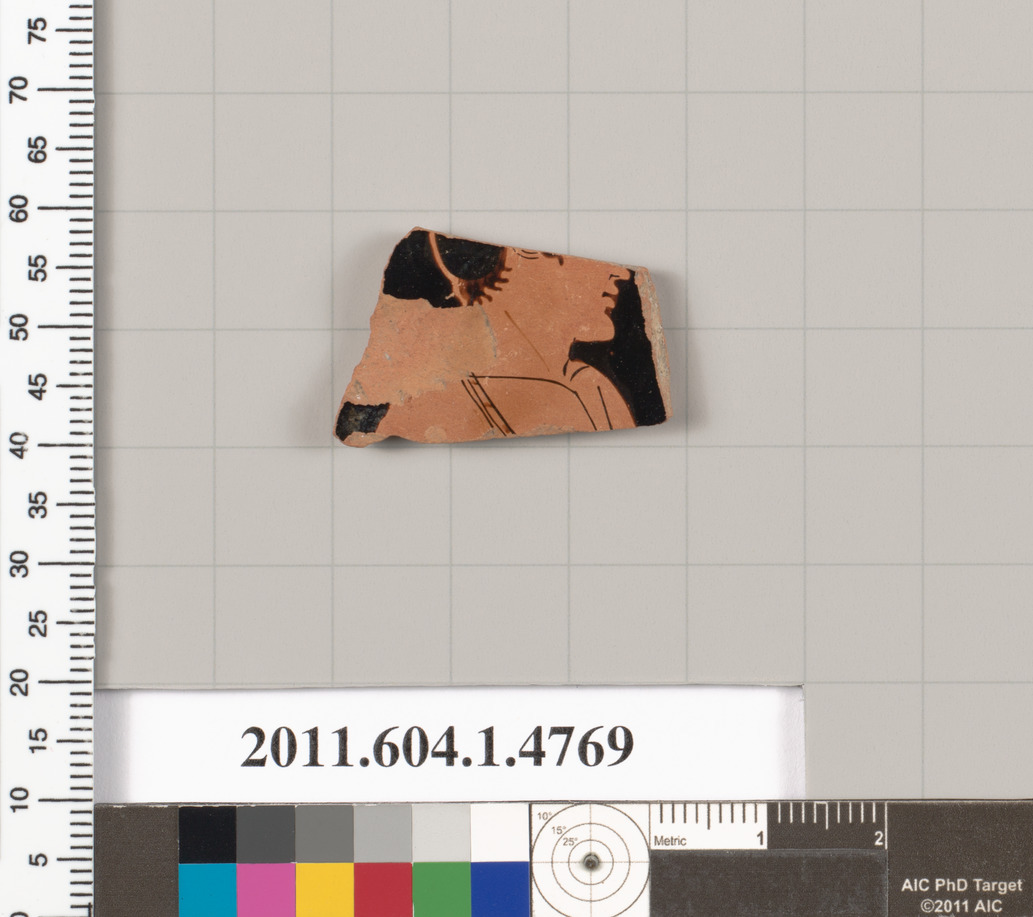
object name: kylix fragment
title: Terracotta fragment of a kylix (drinking cup)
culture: greek, attic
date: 480-470 BCE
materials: terracotta